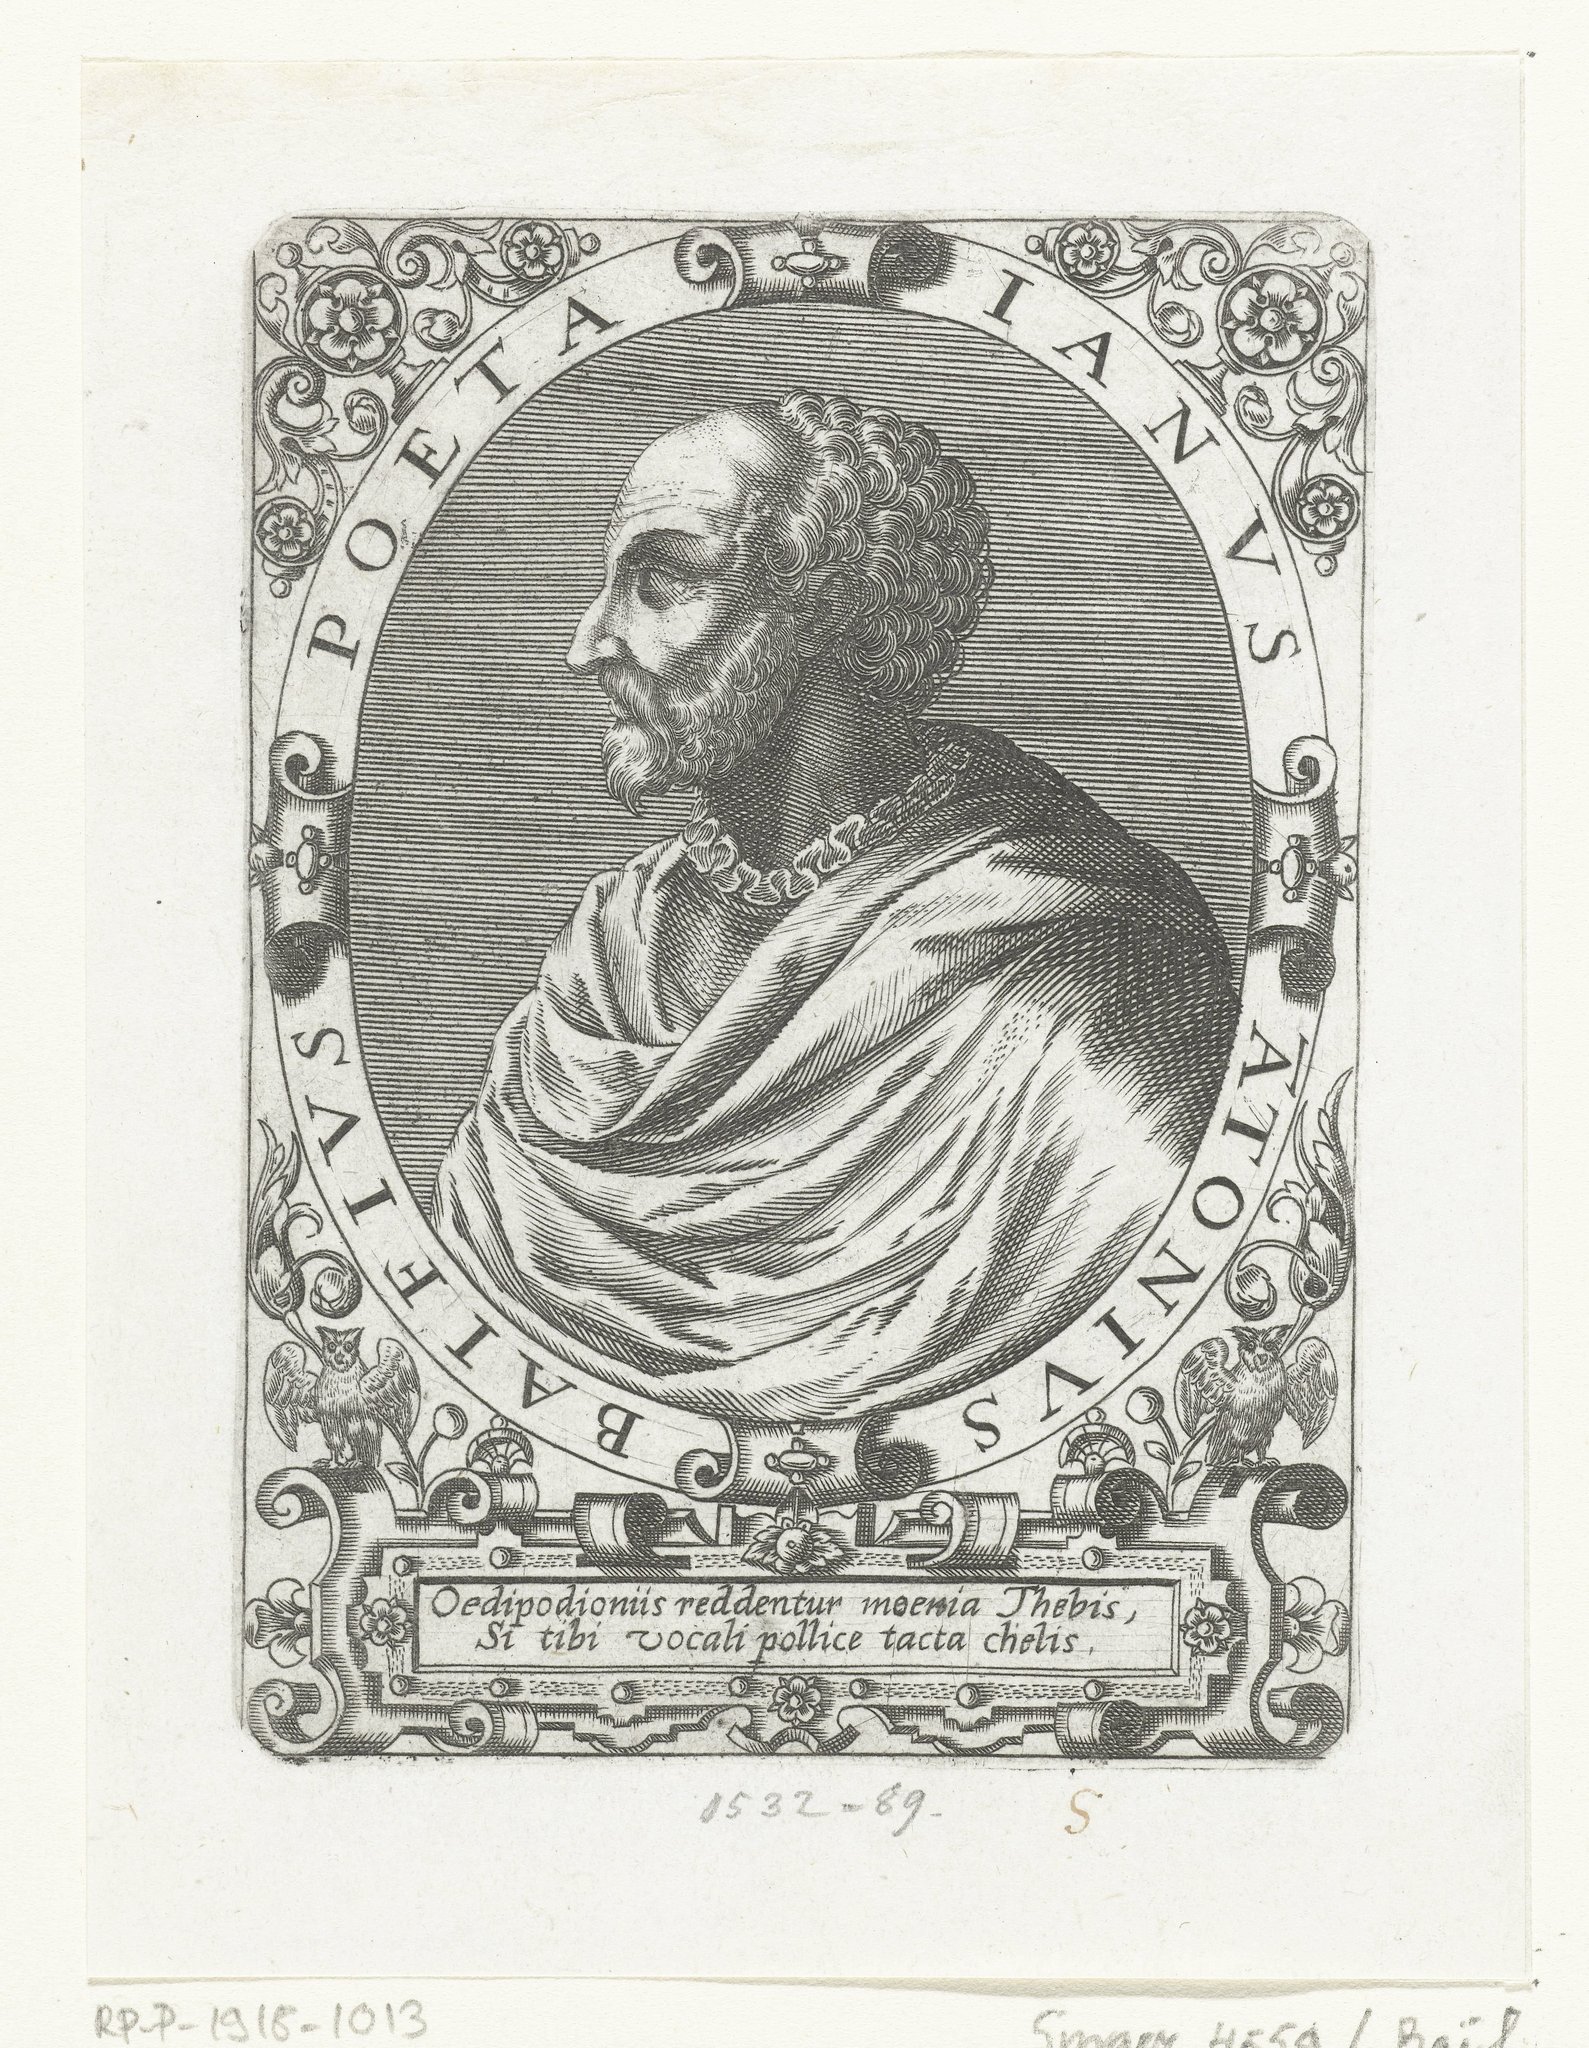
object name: book illustration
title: Portret van Ianus A[n]tonius Baifius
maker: jean jacques boissard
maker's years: 1528-1598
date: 1597-1599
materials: paper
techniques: engraving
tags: venice, paris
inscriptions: collector's mark: Lugt 2228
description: Portret van de Franse dichter Jean Antoine de Baïf, in ovaal met randschrift. Met een sierlijst met bladranken en uilen en een cartouche met een Latijns vers onder het portret